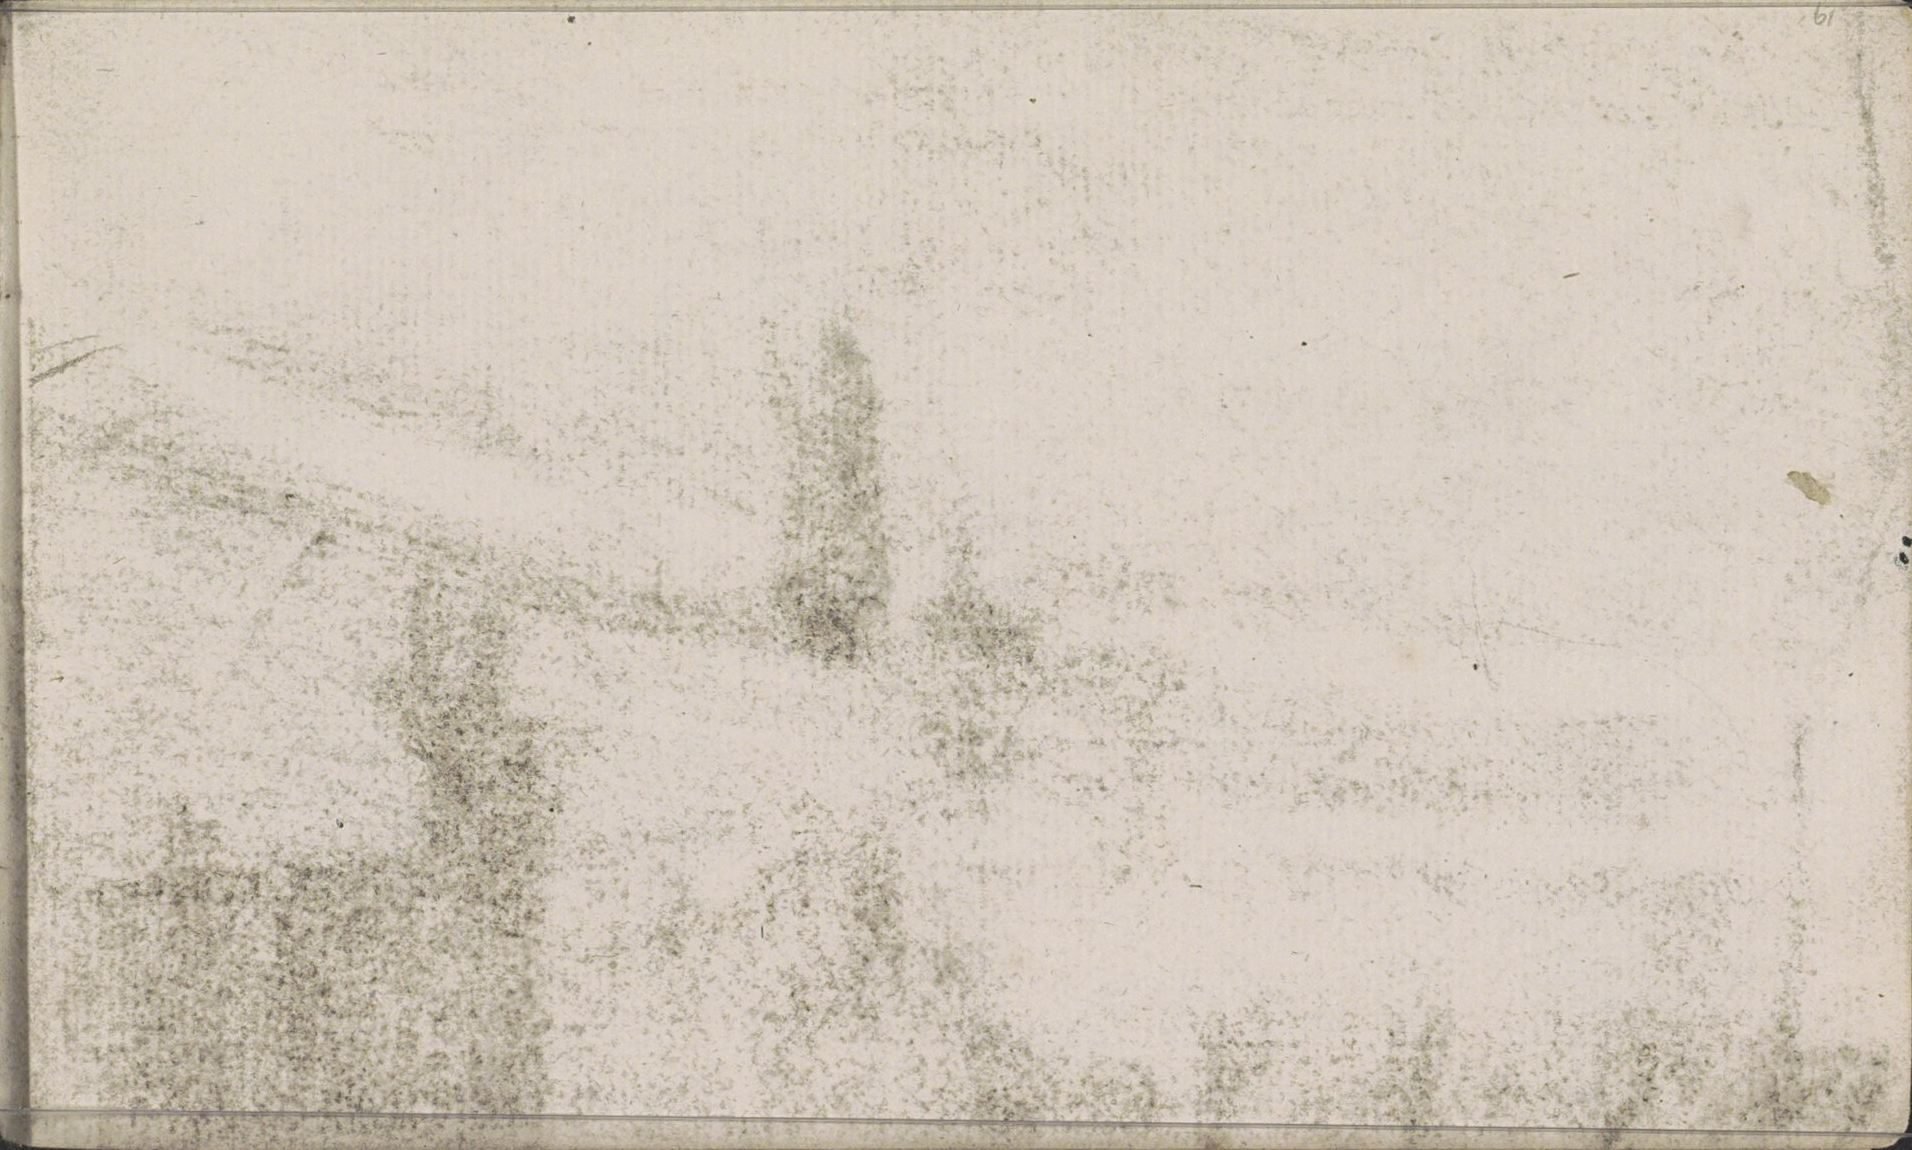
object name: sketchbook leaf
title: Abklatsch van de krijttekening op pagina 60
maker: isaac israels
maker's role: draughtsman, painter, print maker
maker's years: 1865-1934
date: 1875-1934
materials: paper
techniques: printmaking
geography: the hague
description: Pagina 61 uit schetsboek XLVIII met 62 pagina's.